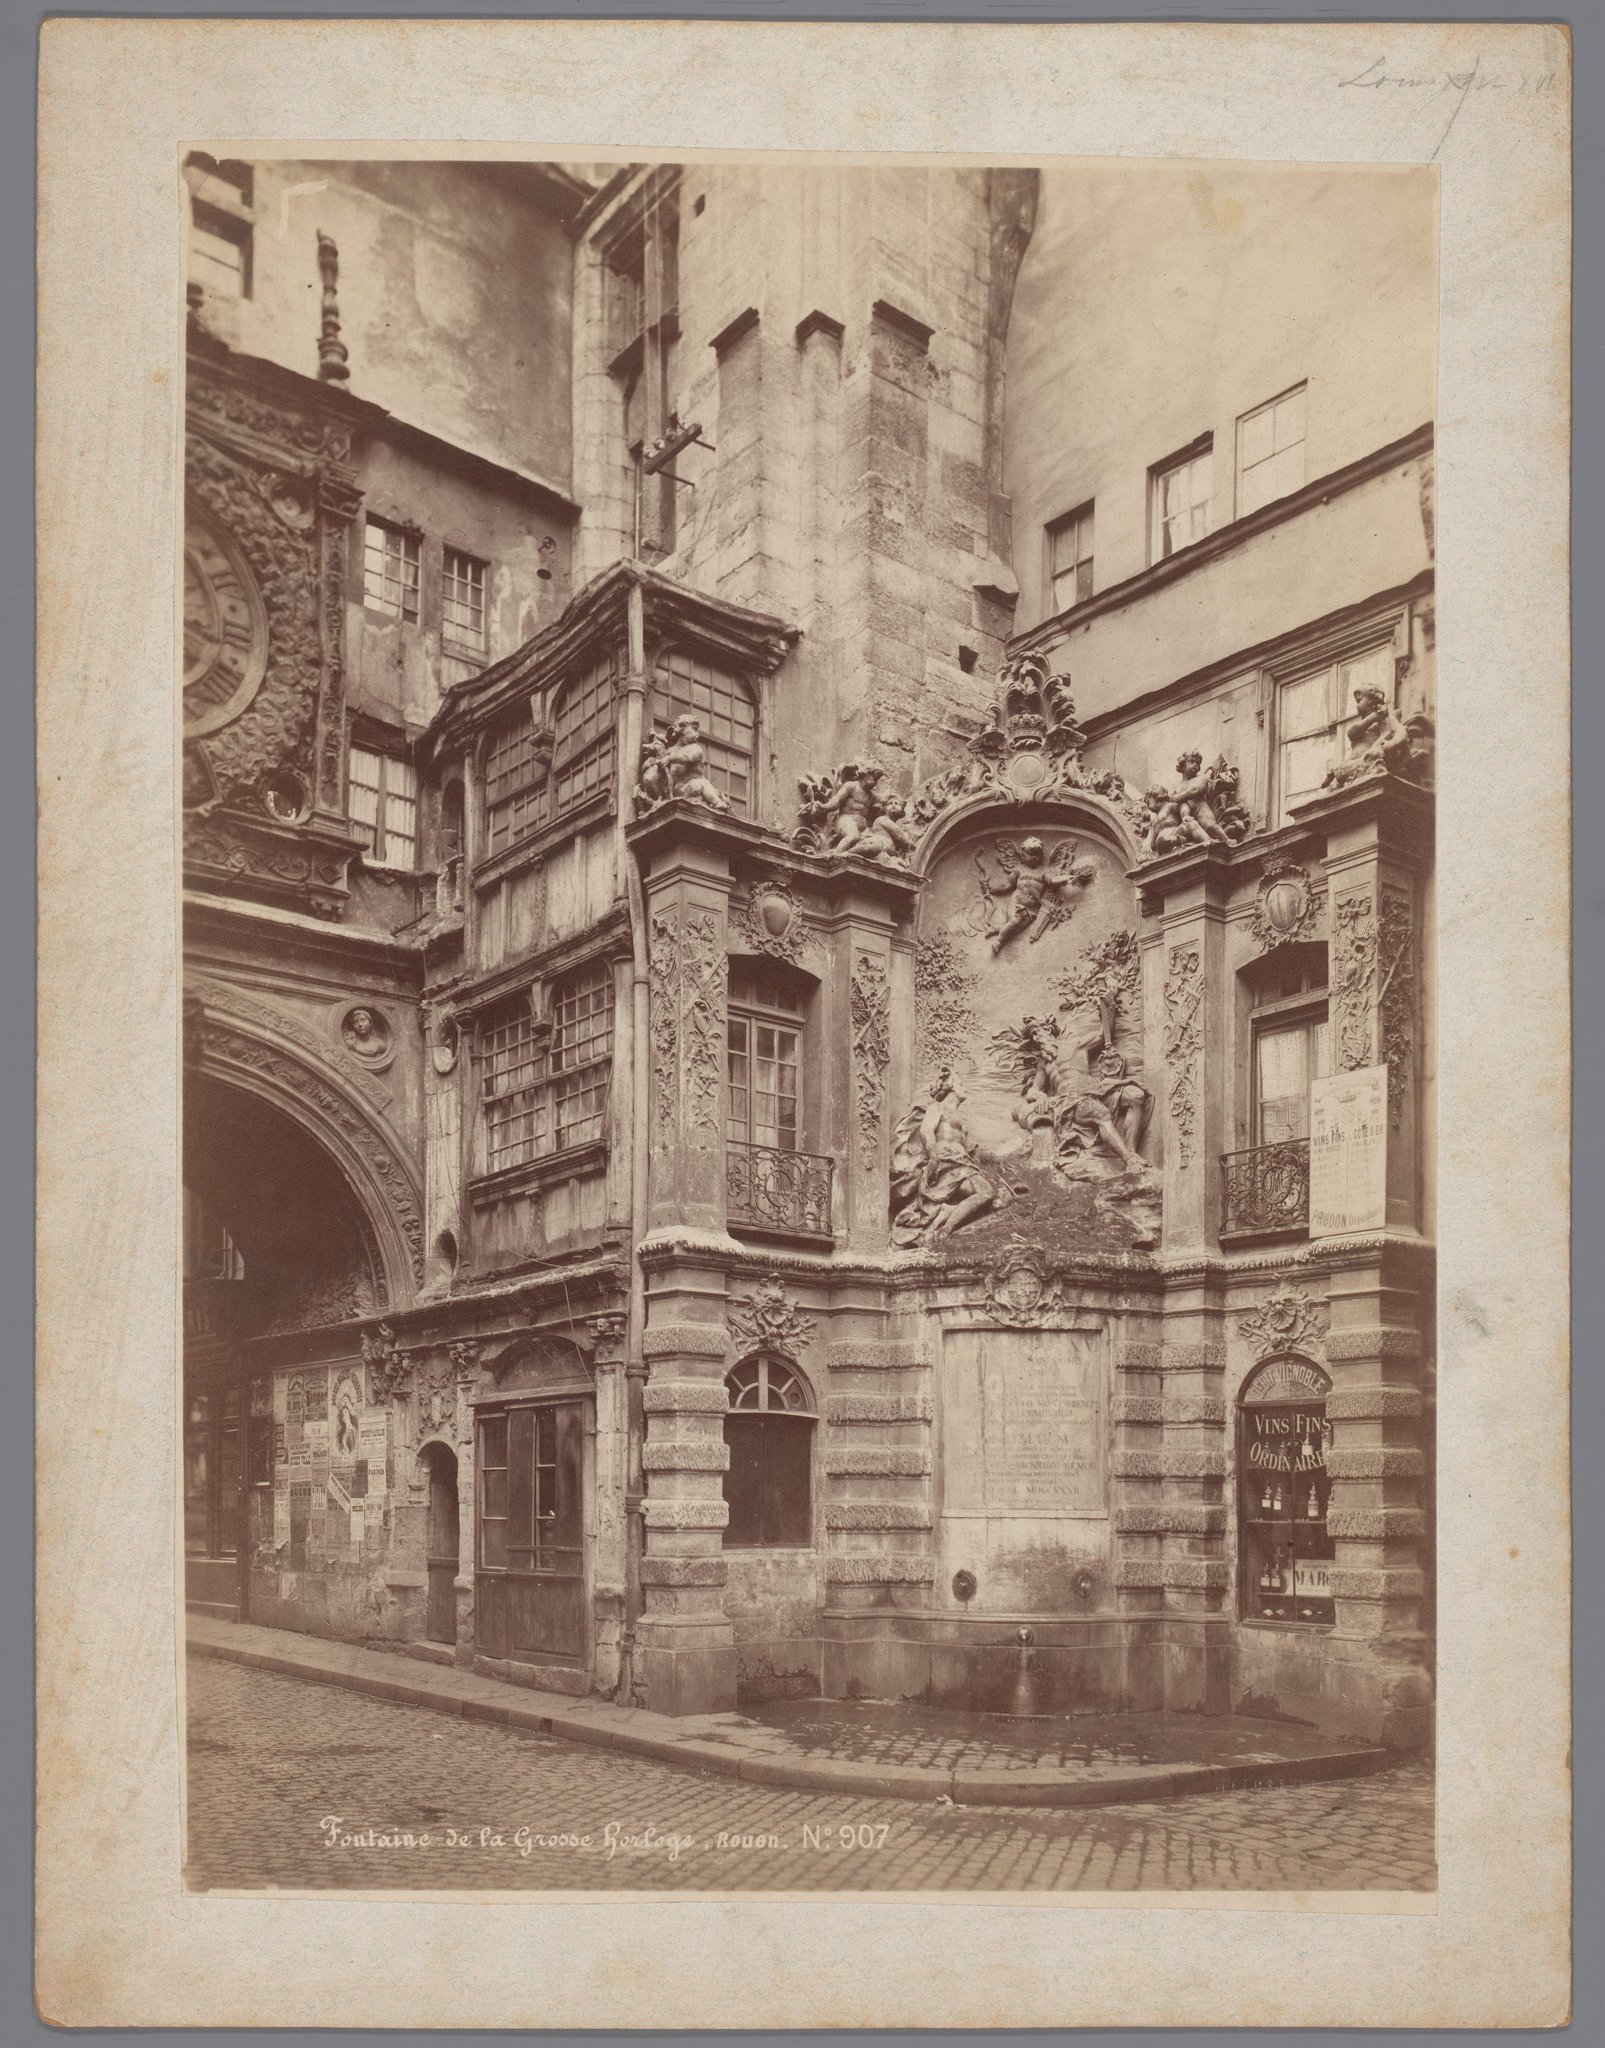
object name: photograph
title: Gezicht op de hoek naast la Grosse horloge te Rouen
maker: Anonymous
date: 1850-1900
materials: cardboard, photographic support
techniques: albumen print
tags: clock, street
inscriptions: number: ‘N0. 907’, collector's mark: Lugt 3937